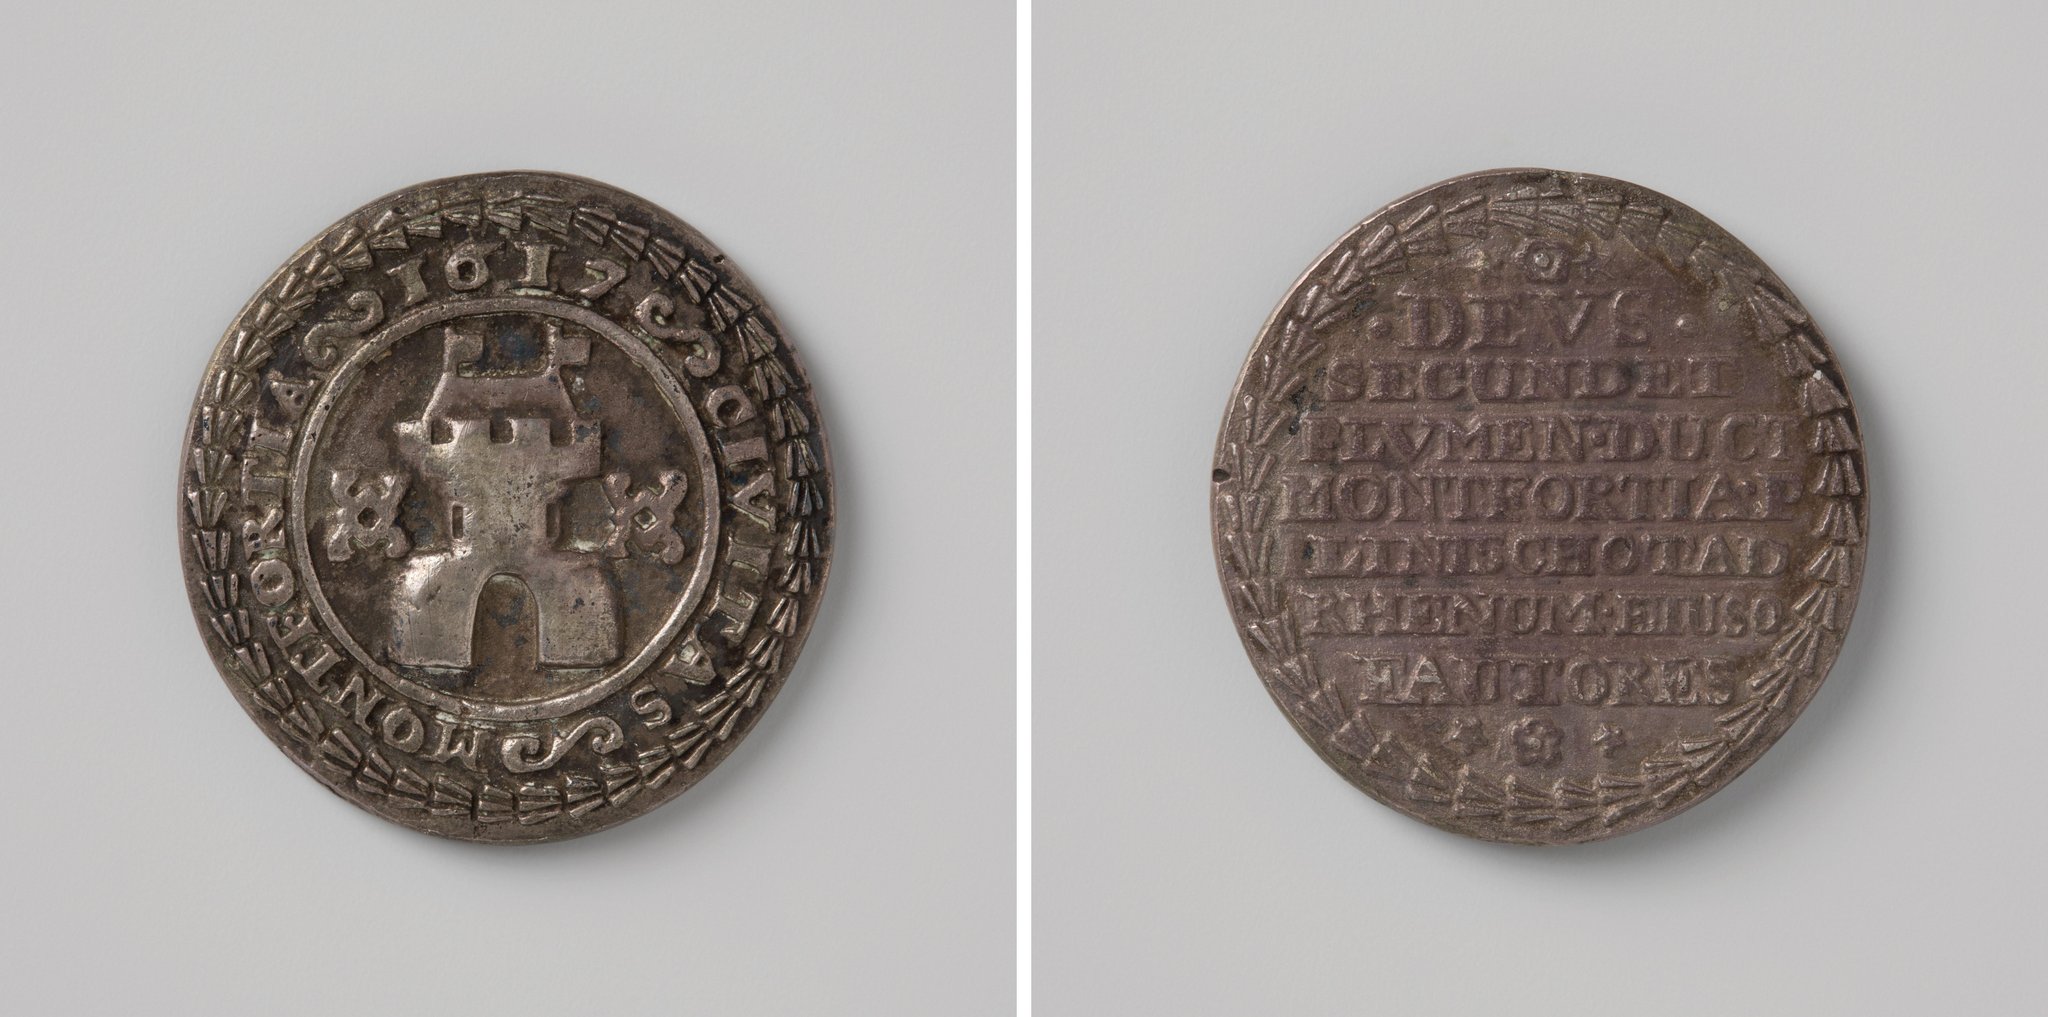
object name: history medal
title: Voltooing van het kanaal van Montfoort door Linschoten tot aan de Rijn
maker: Anonymous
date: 1617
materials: silver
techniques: casting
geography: netherlands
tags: montfoort, linschoten, montfoortse vaart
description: Zilveren penning. Voorzijde: wapenschild voorstellende burcht tussen twee molenijzers. Keerzijde: opschrift